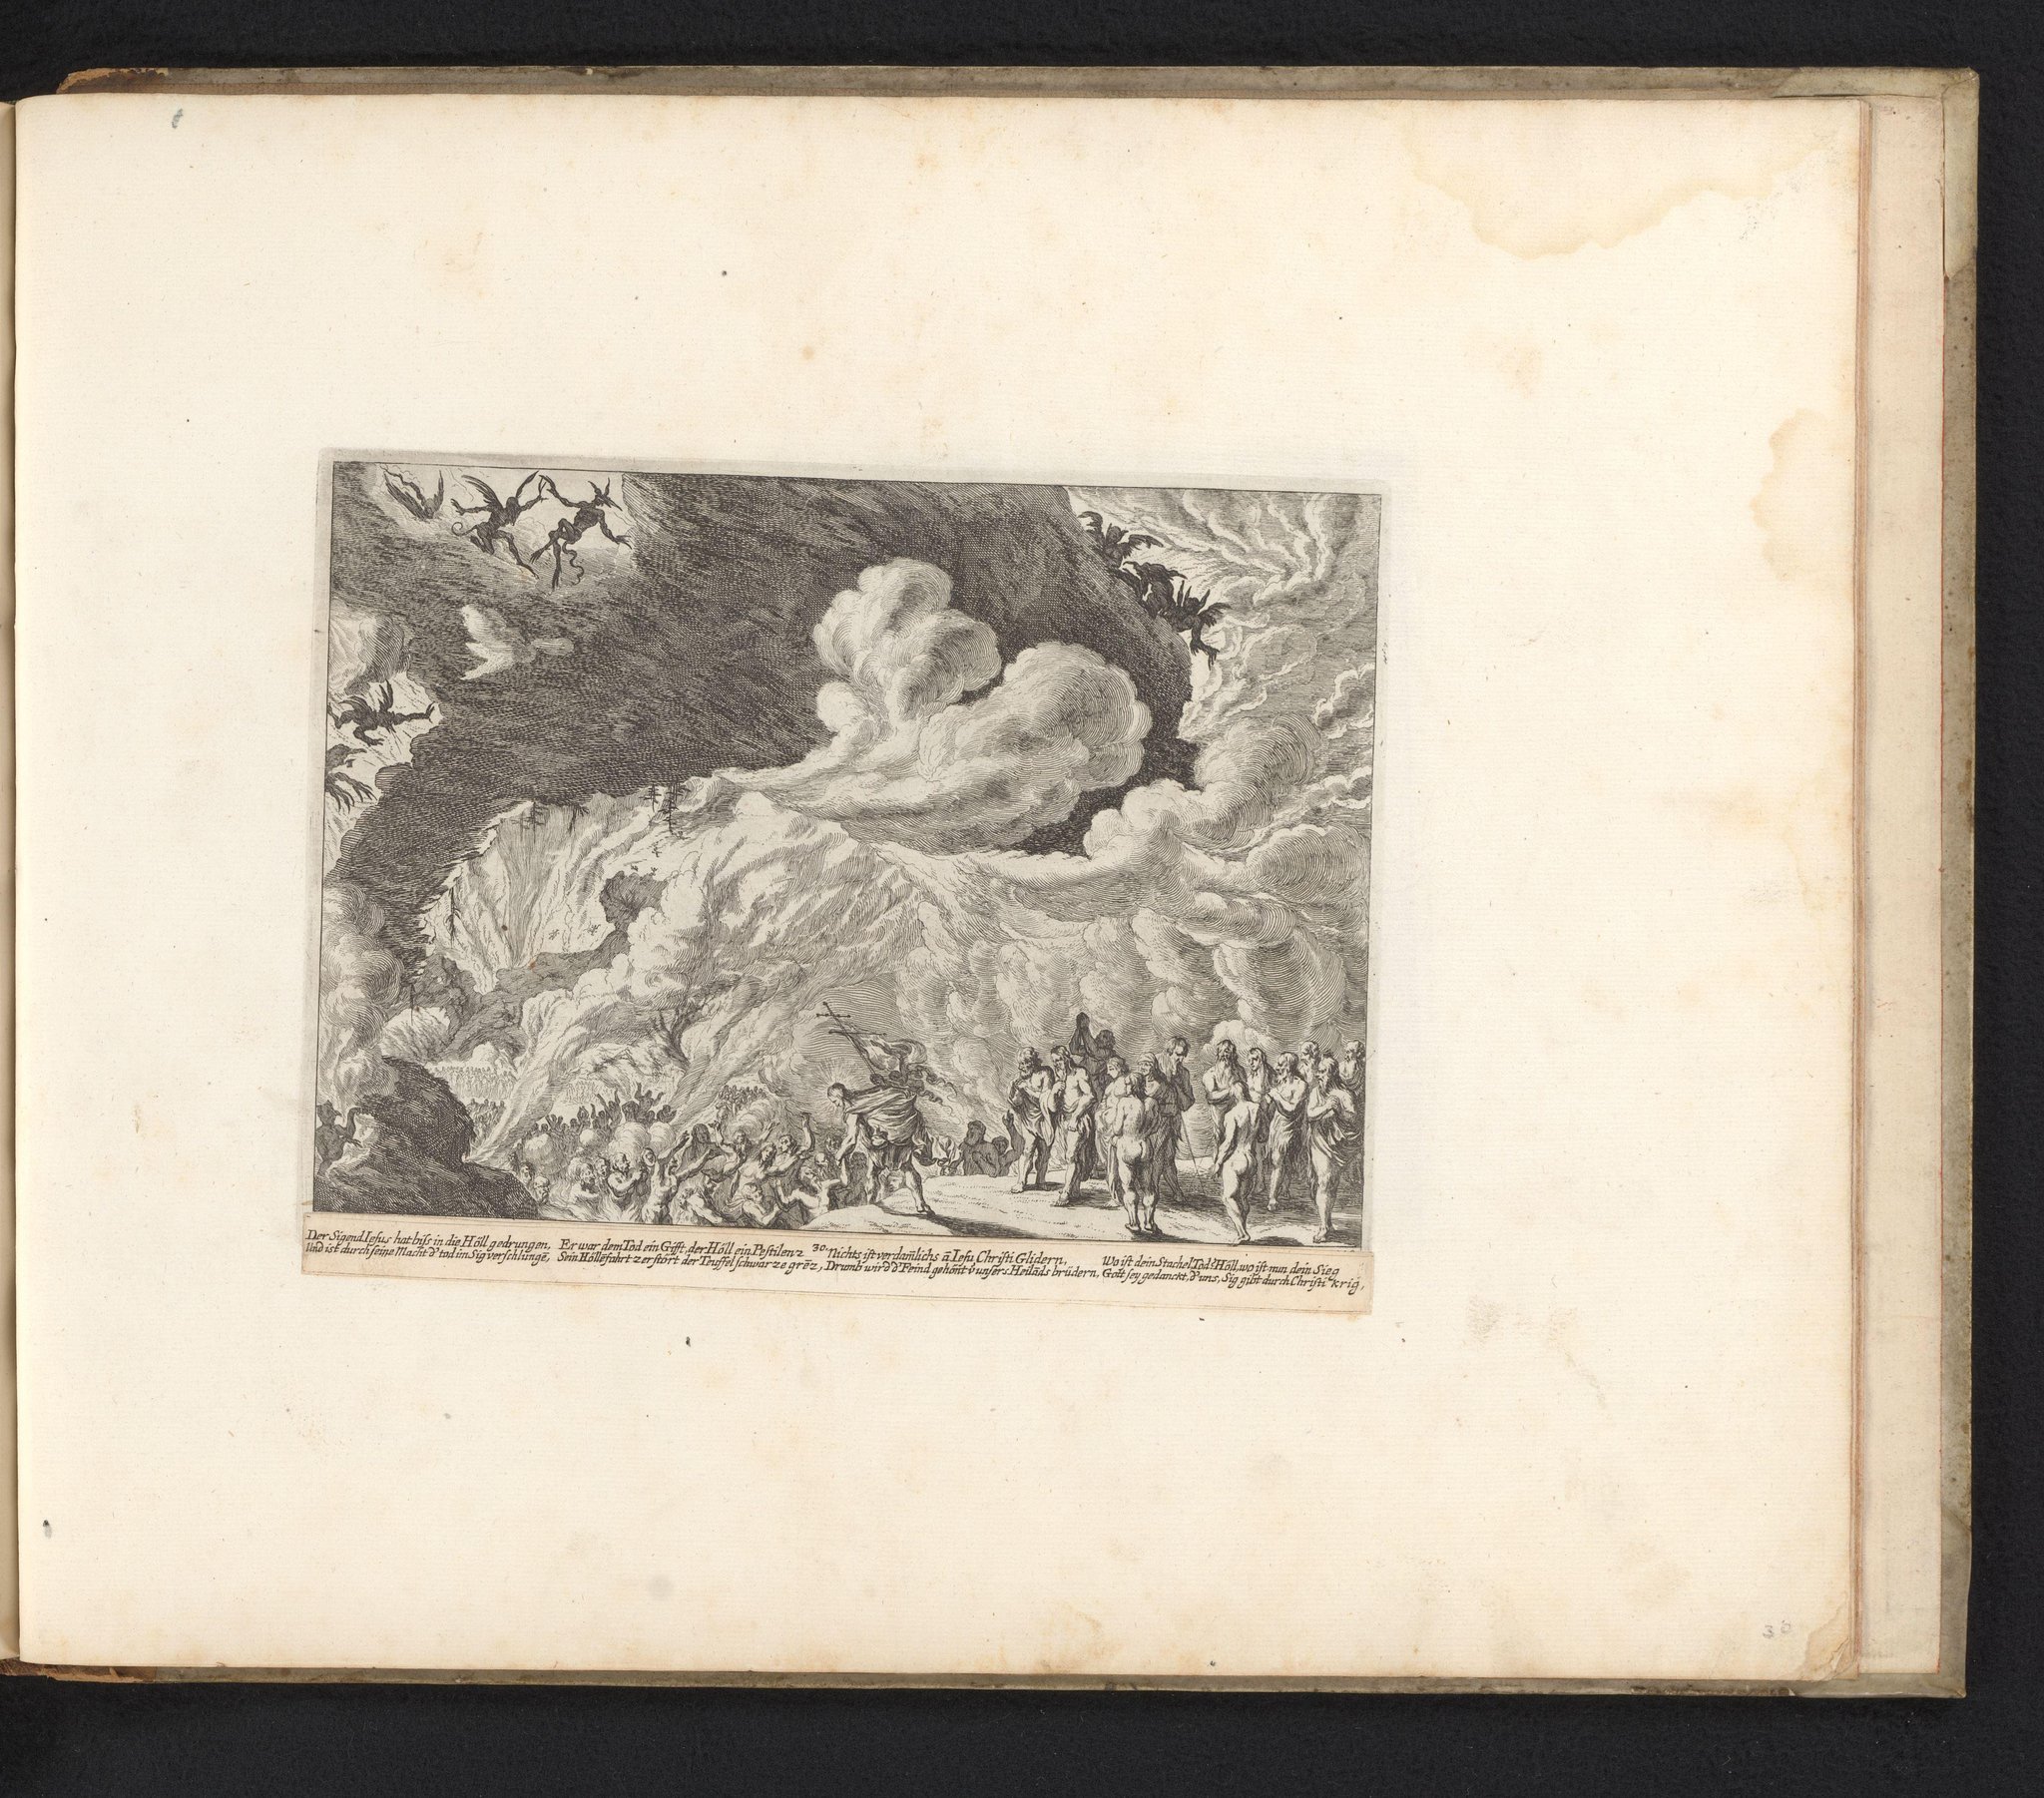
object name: print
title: Afdaling in het voorgeborchte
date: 1670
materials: paper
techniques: etching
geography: augsburg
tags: christ leaving hell: he liberates patriarchs, prophets, kings and other persons from hell, among them adam, eve, moses, david, and john the baptist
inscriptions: collector's mark: Lugt 2228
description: Tekst in het Duits in de ondermarge. Prent maakt deel uit van een album.